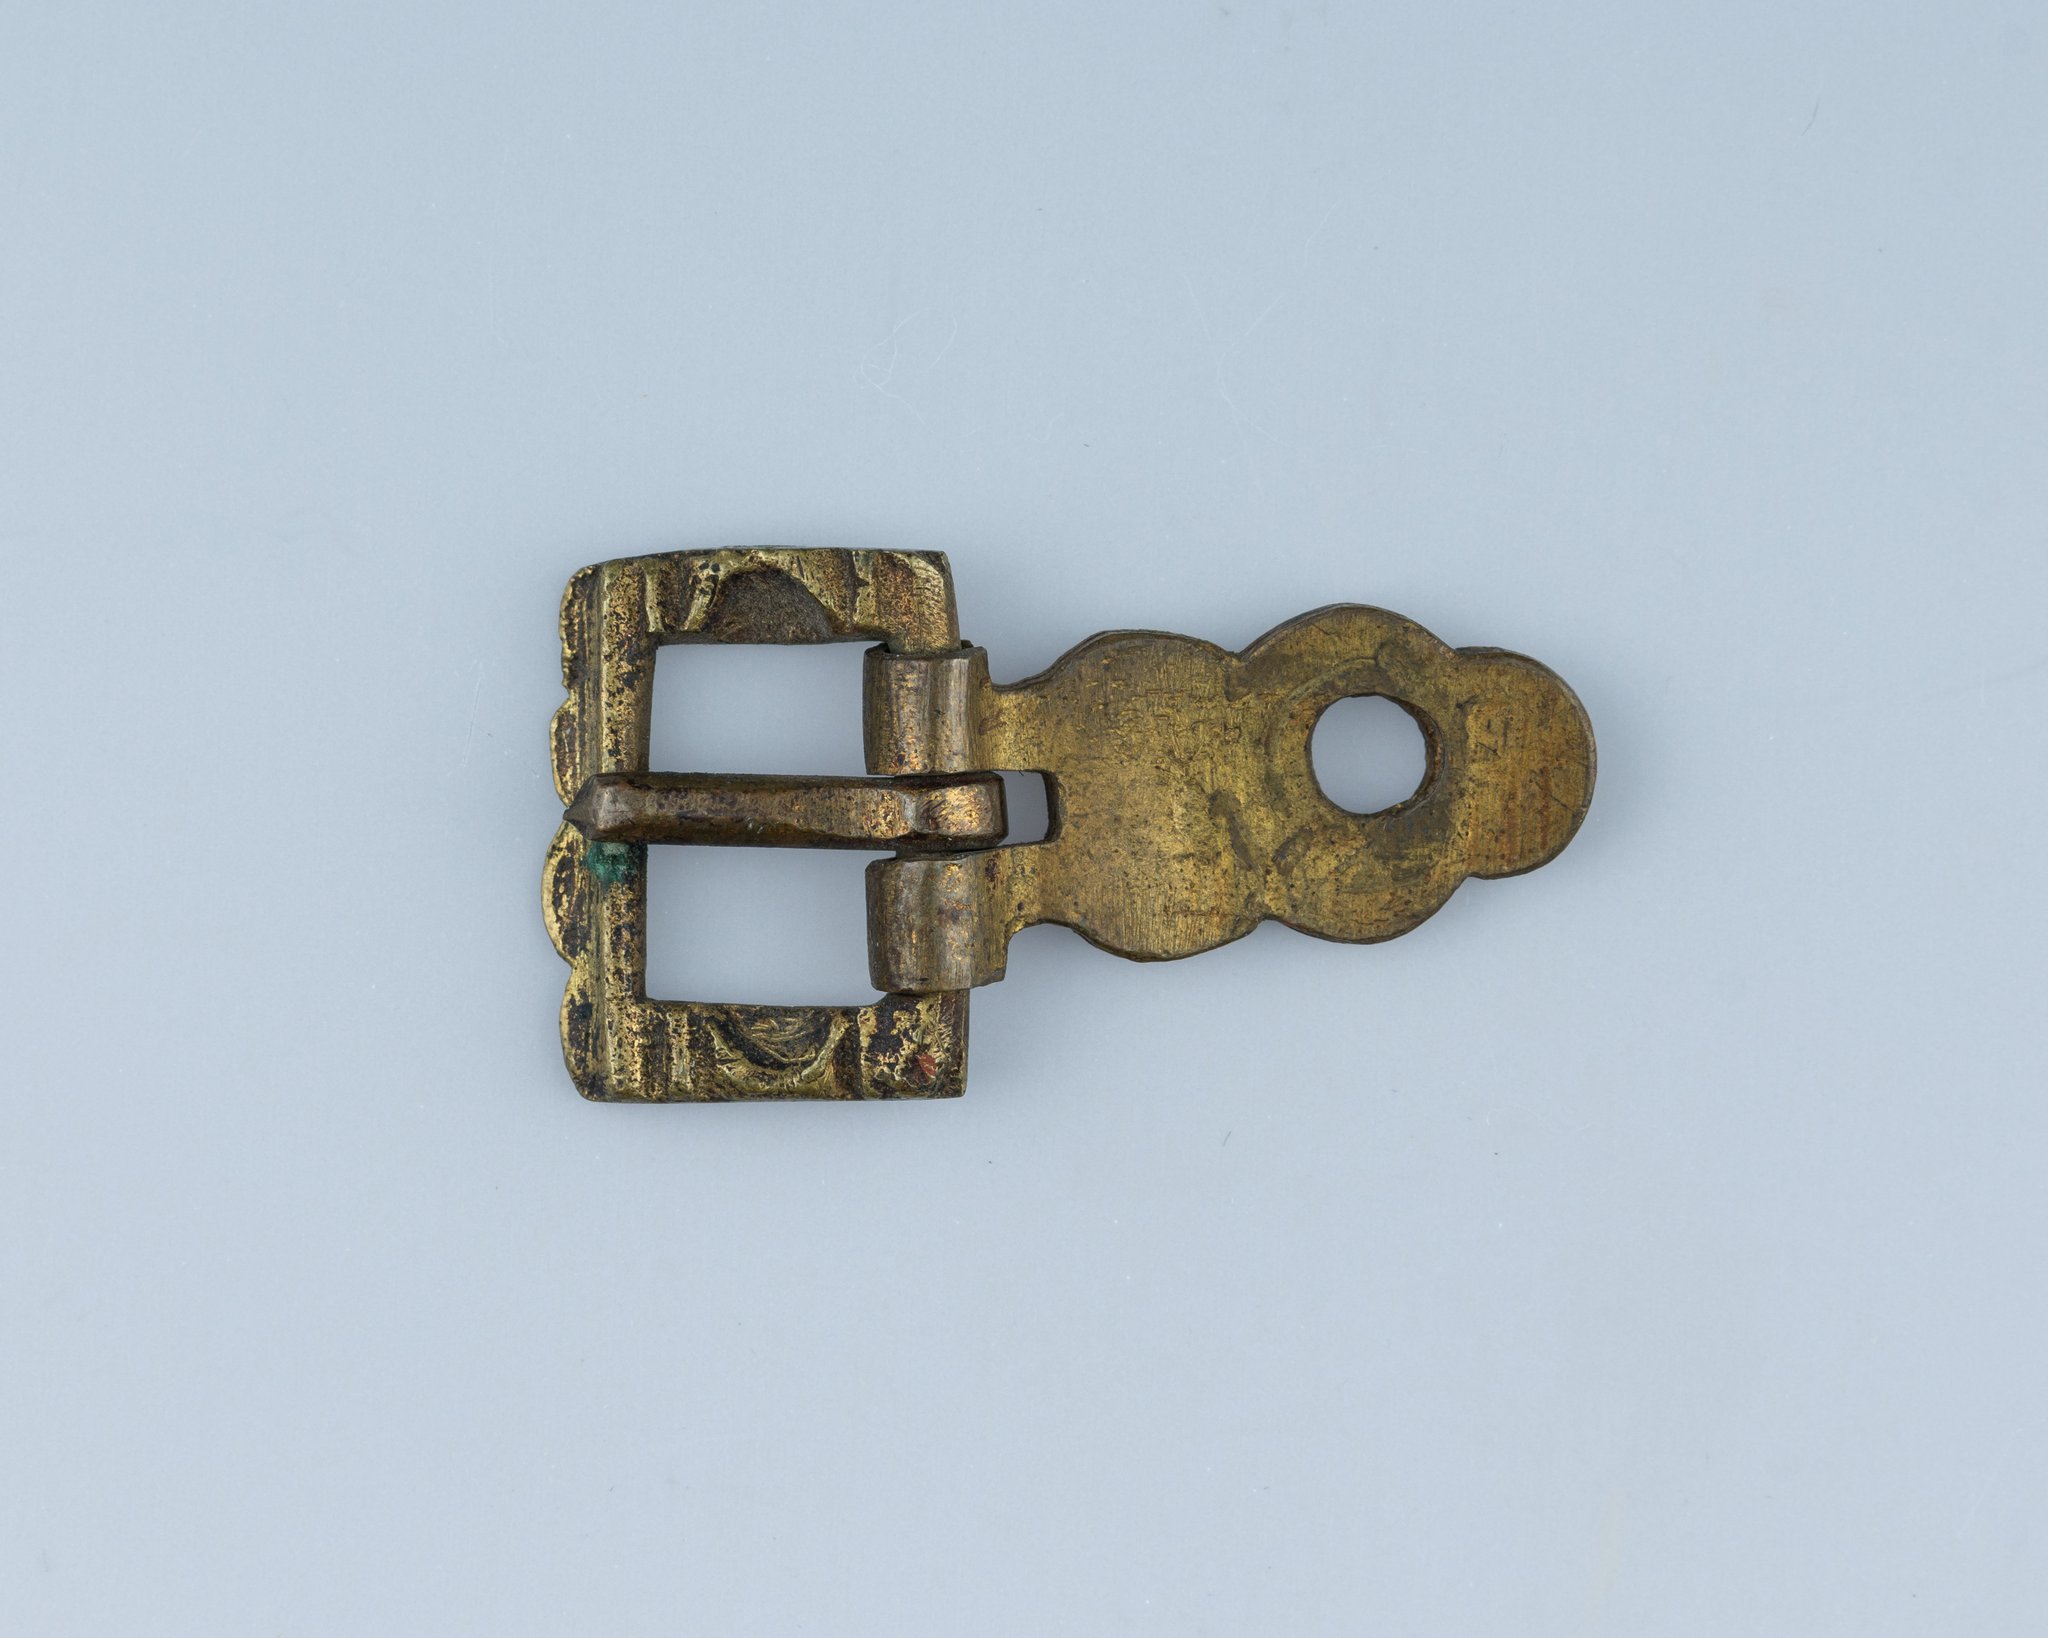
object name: buckle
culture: german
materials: brass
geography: germany